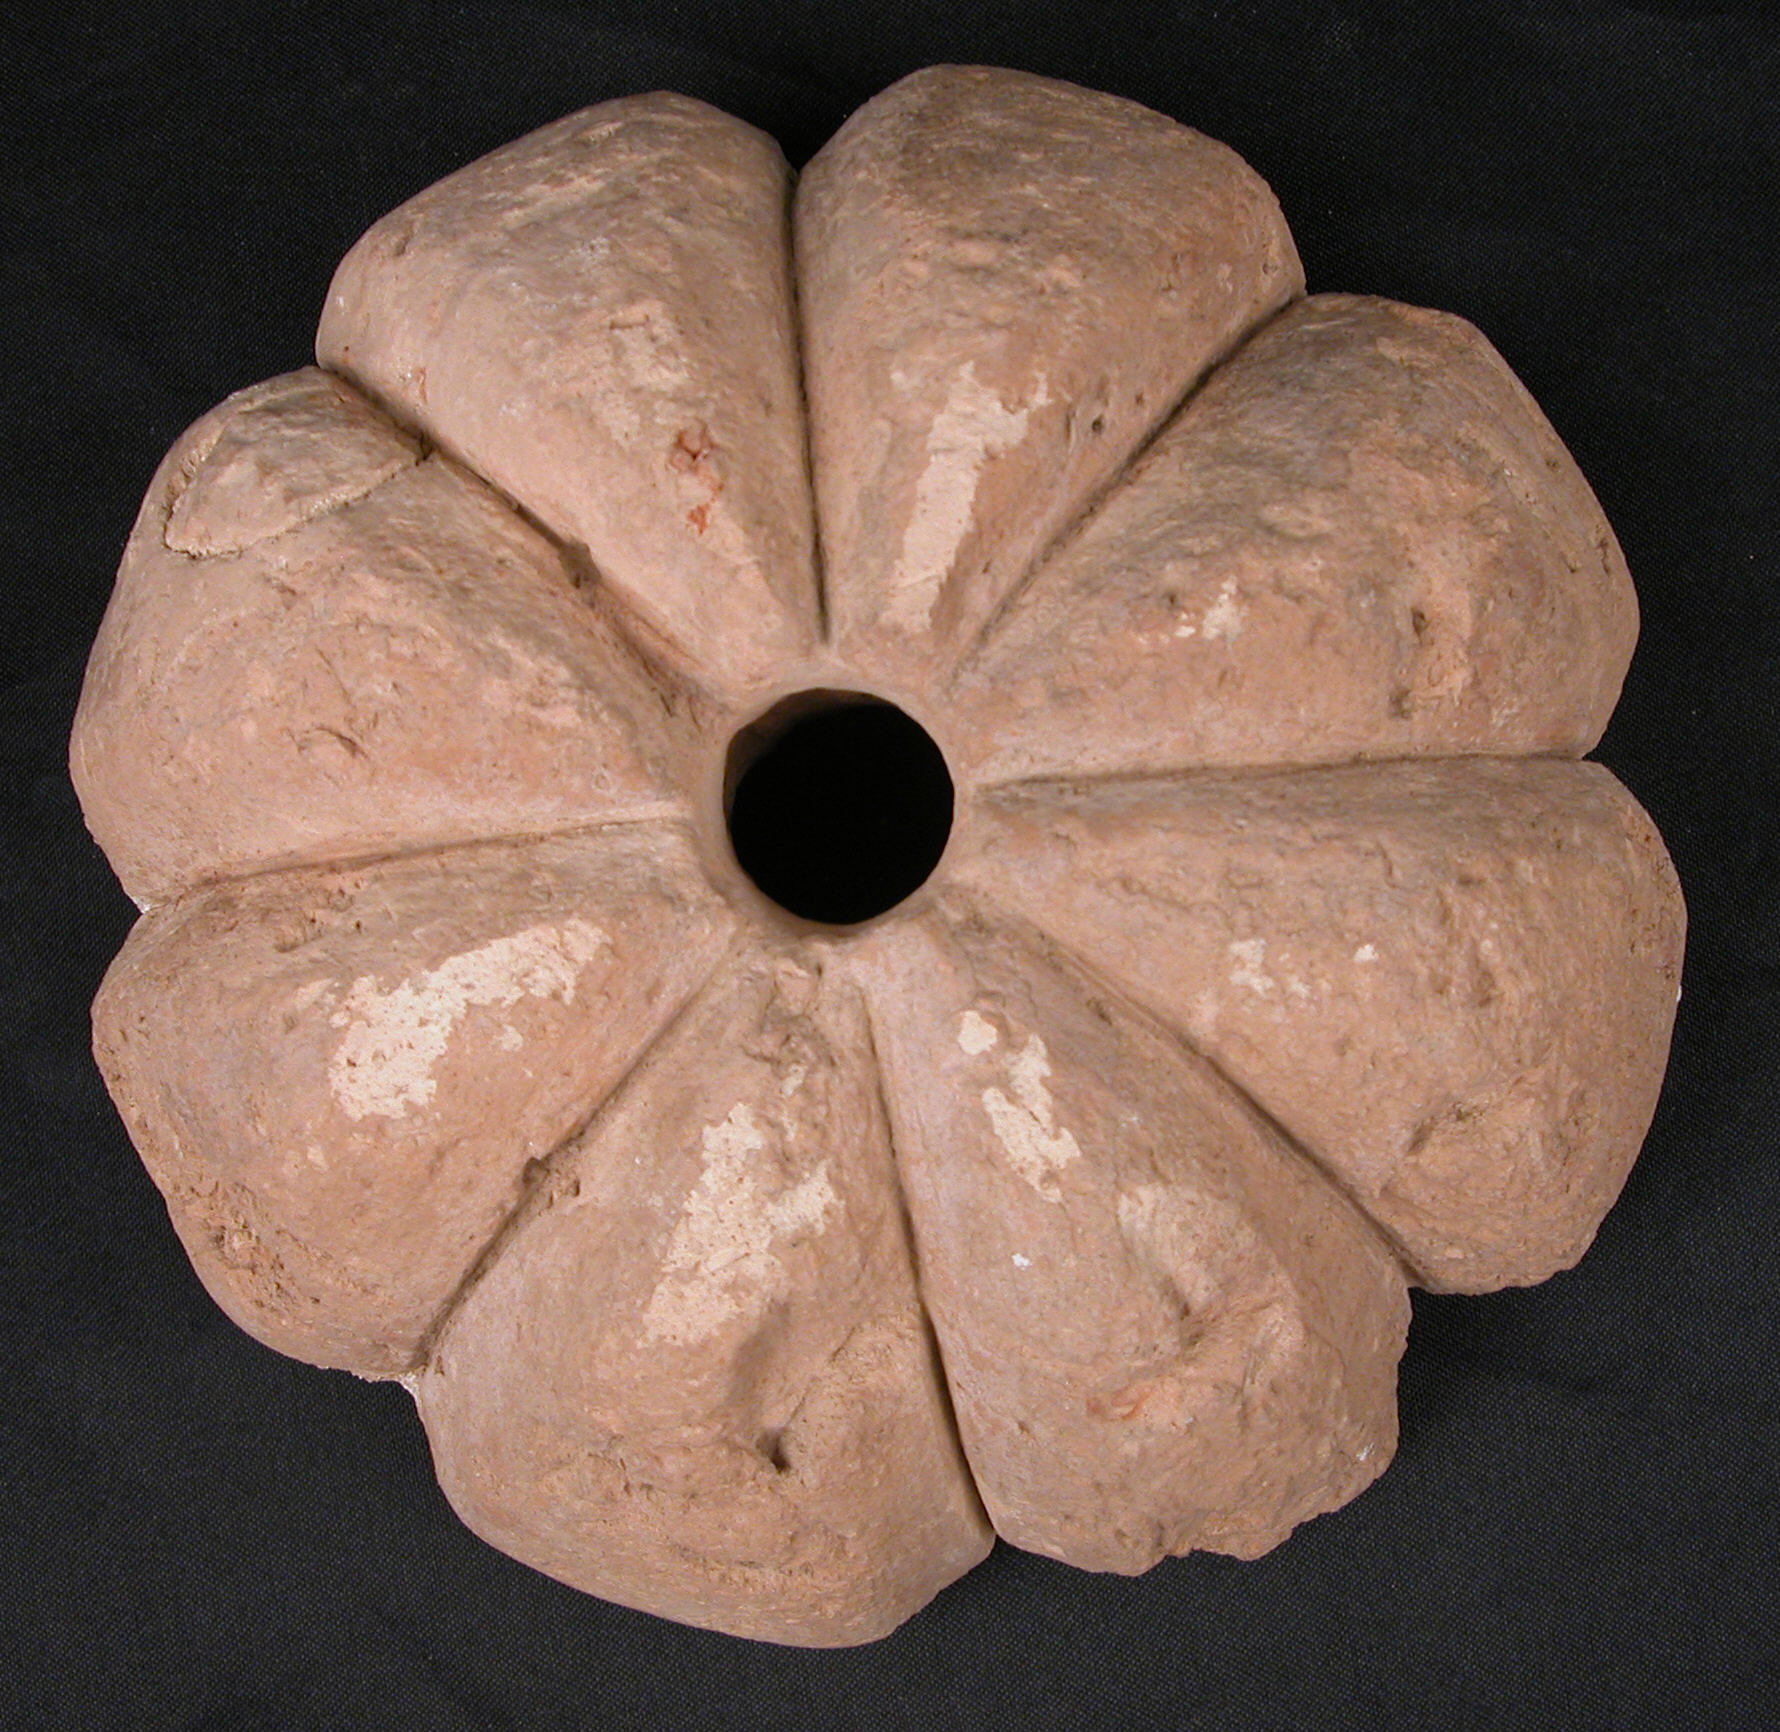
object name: bos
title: Boss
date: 1001-1100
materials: earthenware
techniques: molding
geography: iran